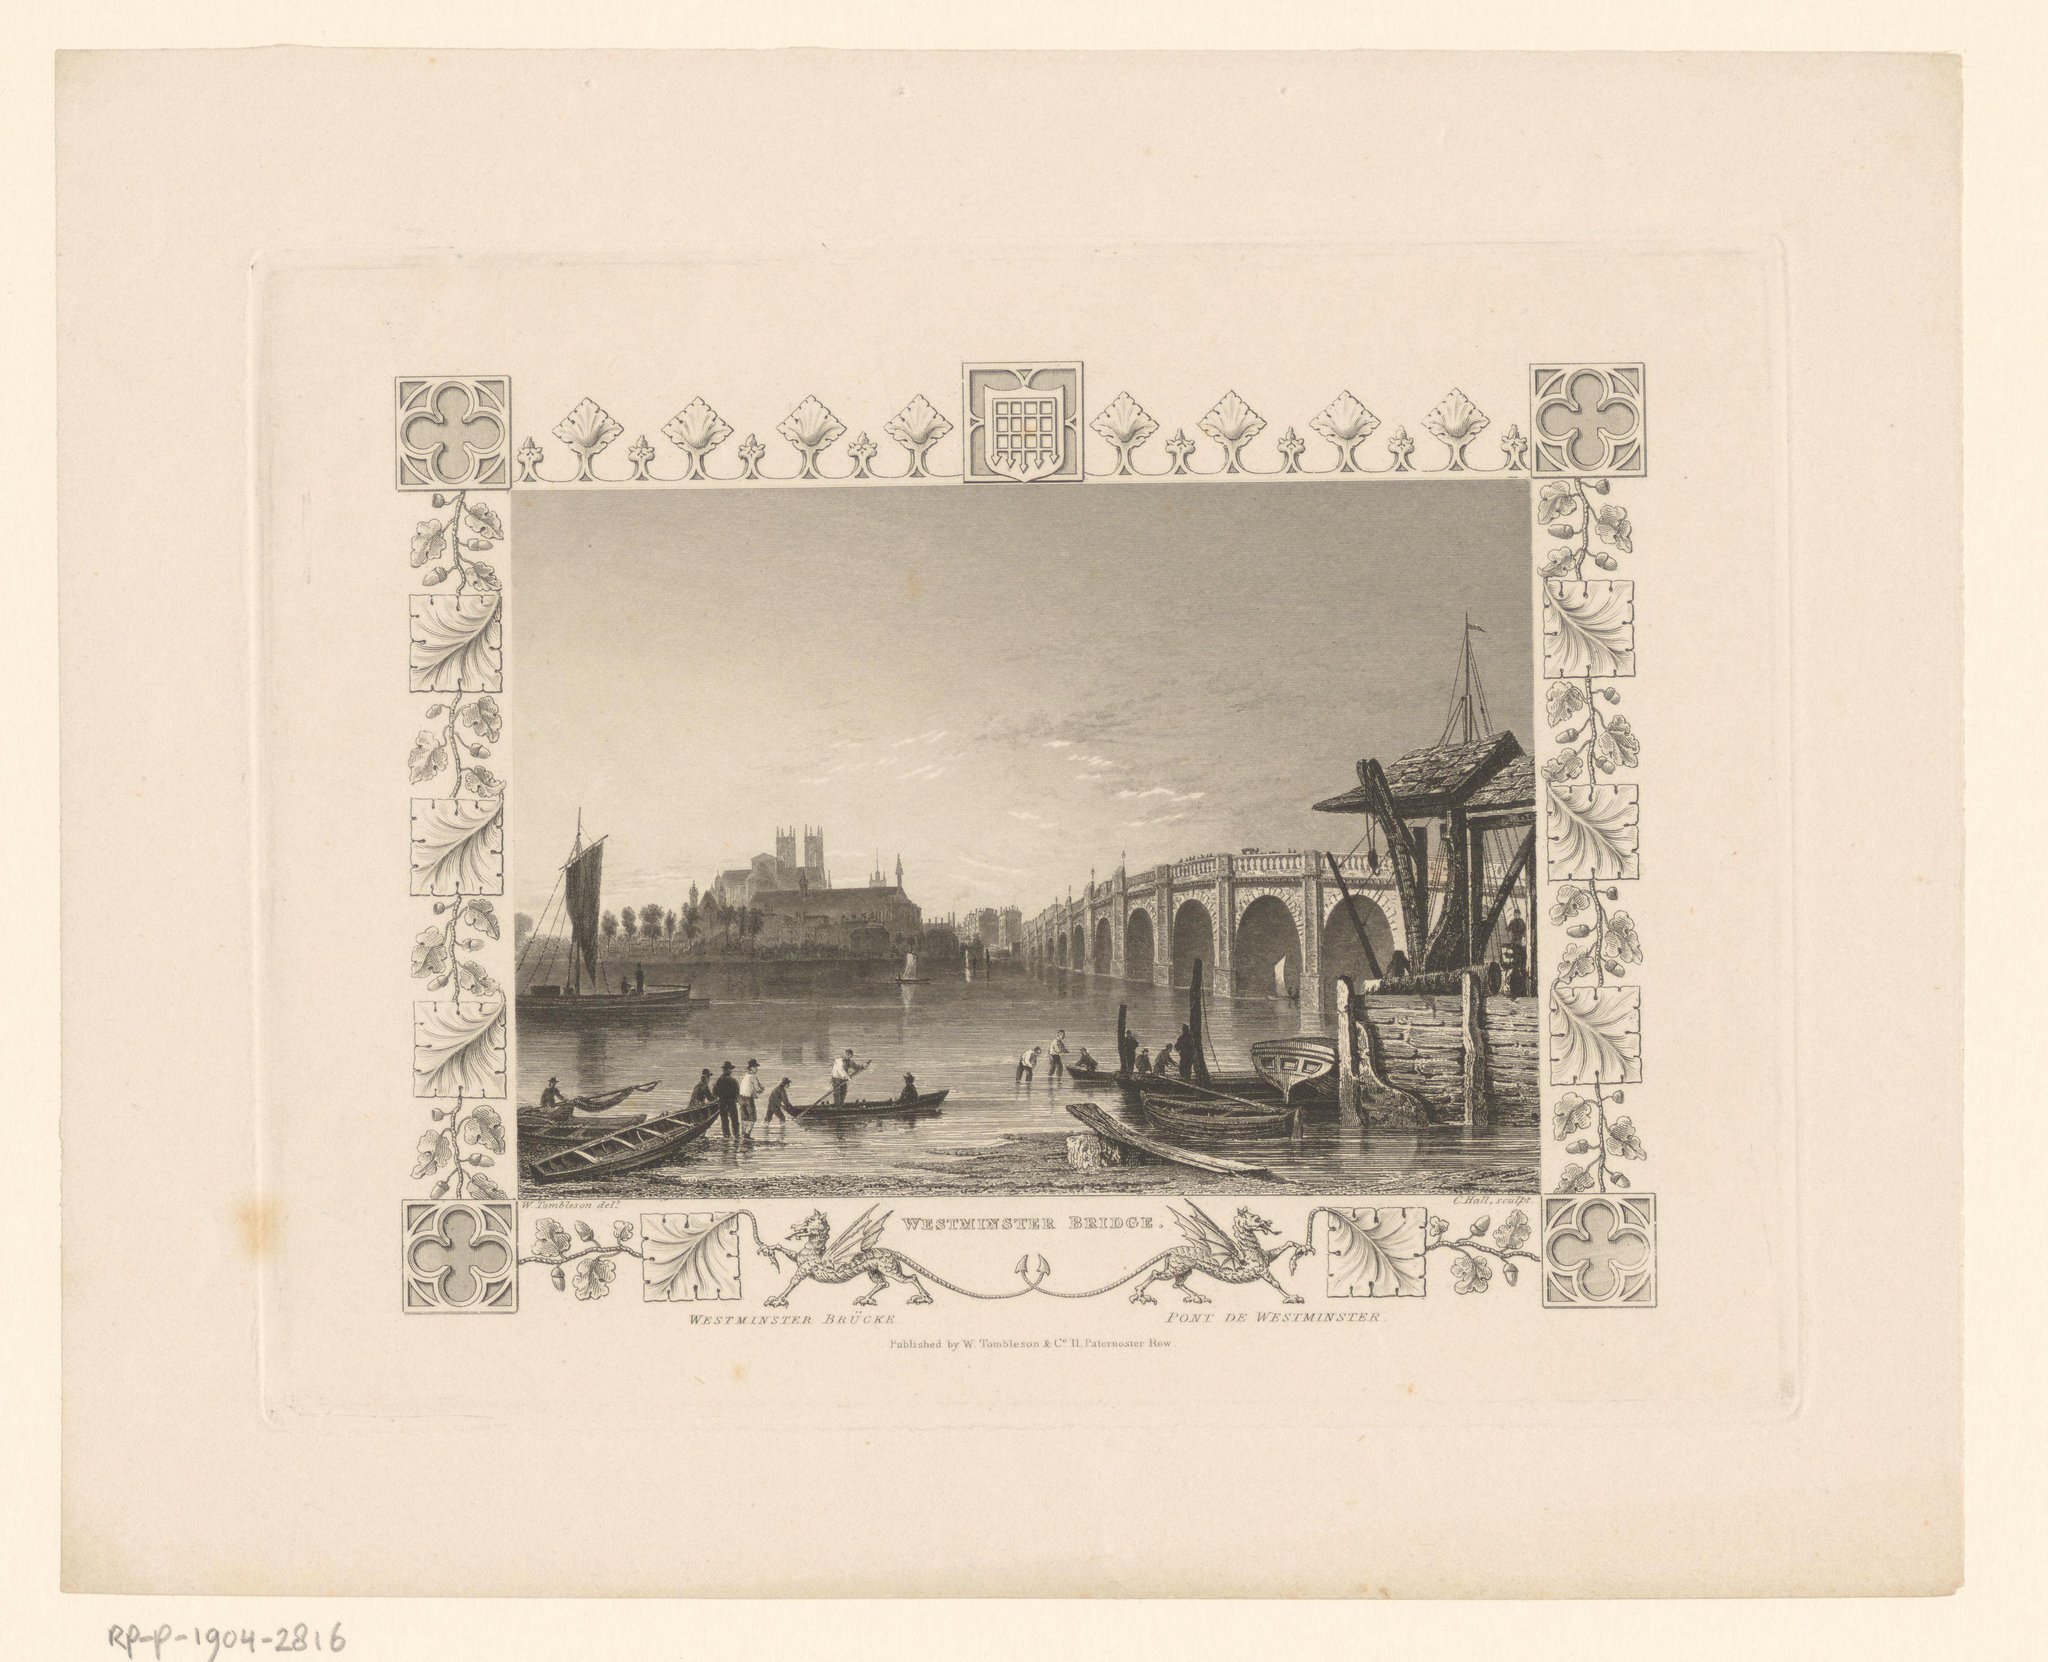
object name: book illustration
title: Gezicht op de Westminster Bridge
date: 1831-1837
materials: paper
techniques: etching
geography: london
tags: rowing-boat, canoe, etc., bridge in city across river, canal, etc.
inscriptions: collector's mark: Lugt 2228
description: Prent uit: Fearnside, W.G. Eighty Picturesque Views of the Thames and Medway (...). Londen: Black & Armstrong, [ca. 1831-1837].